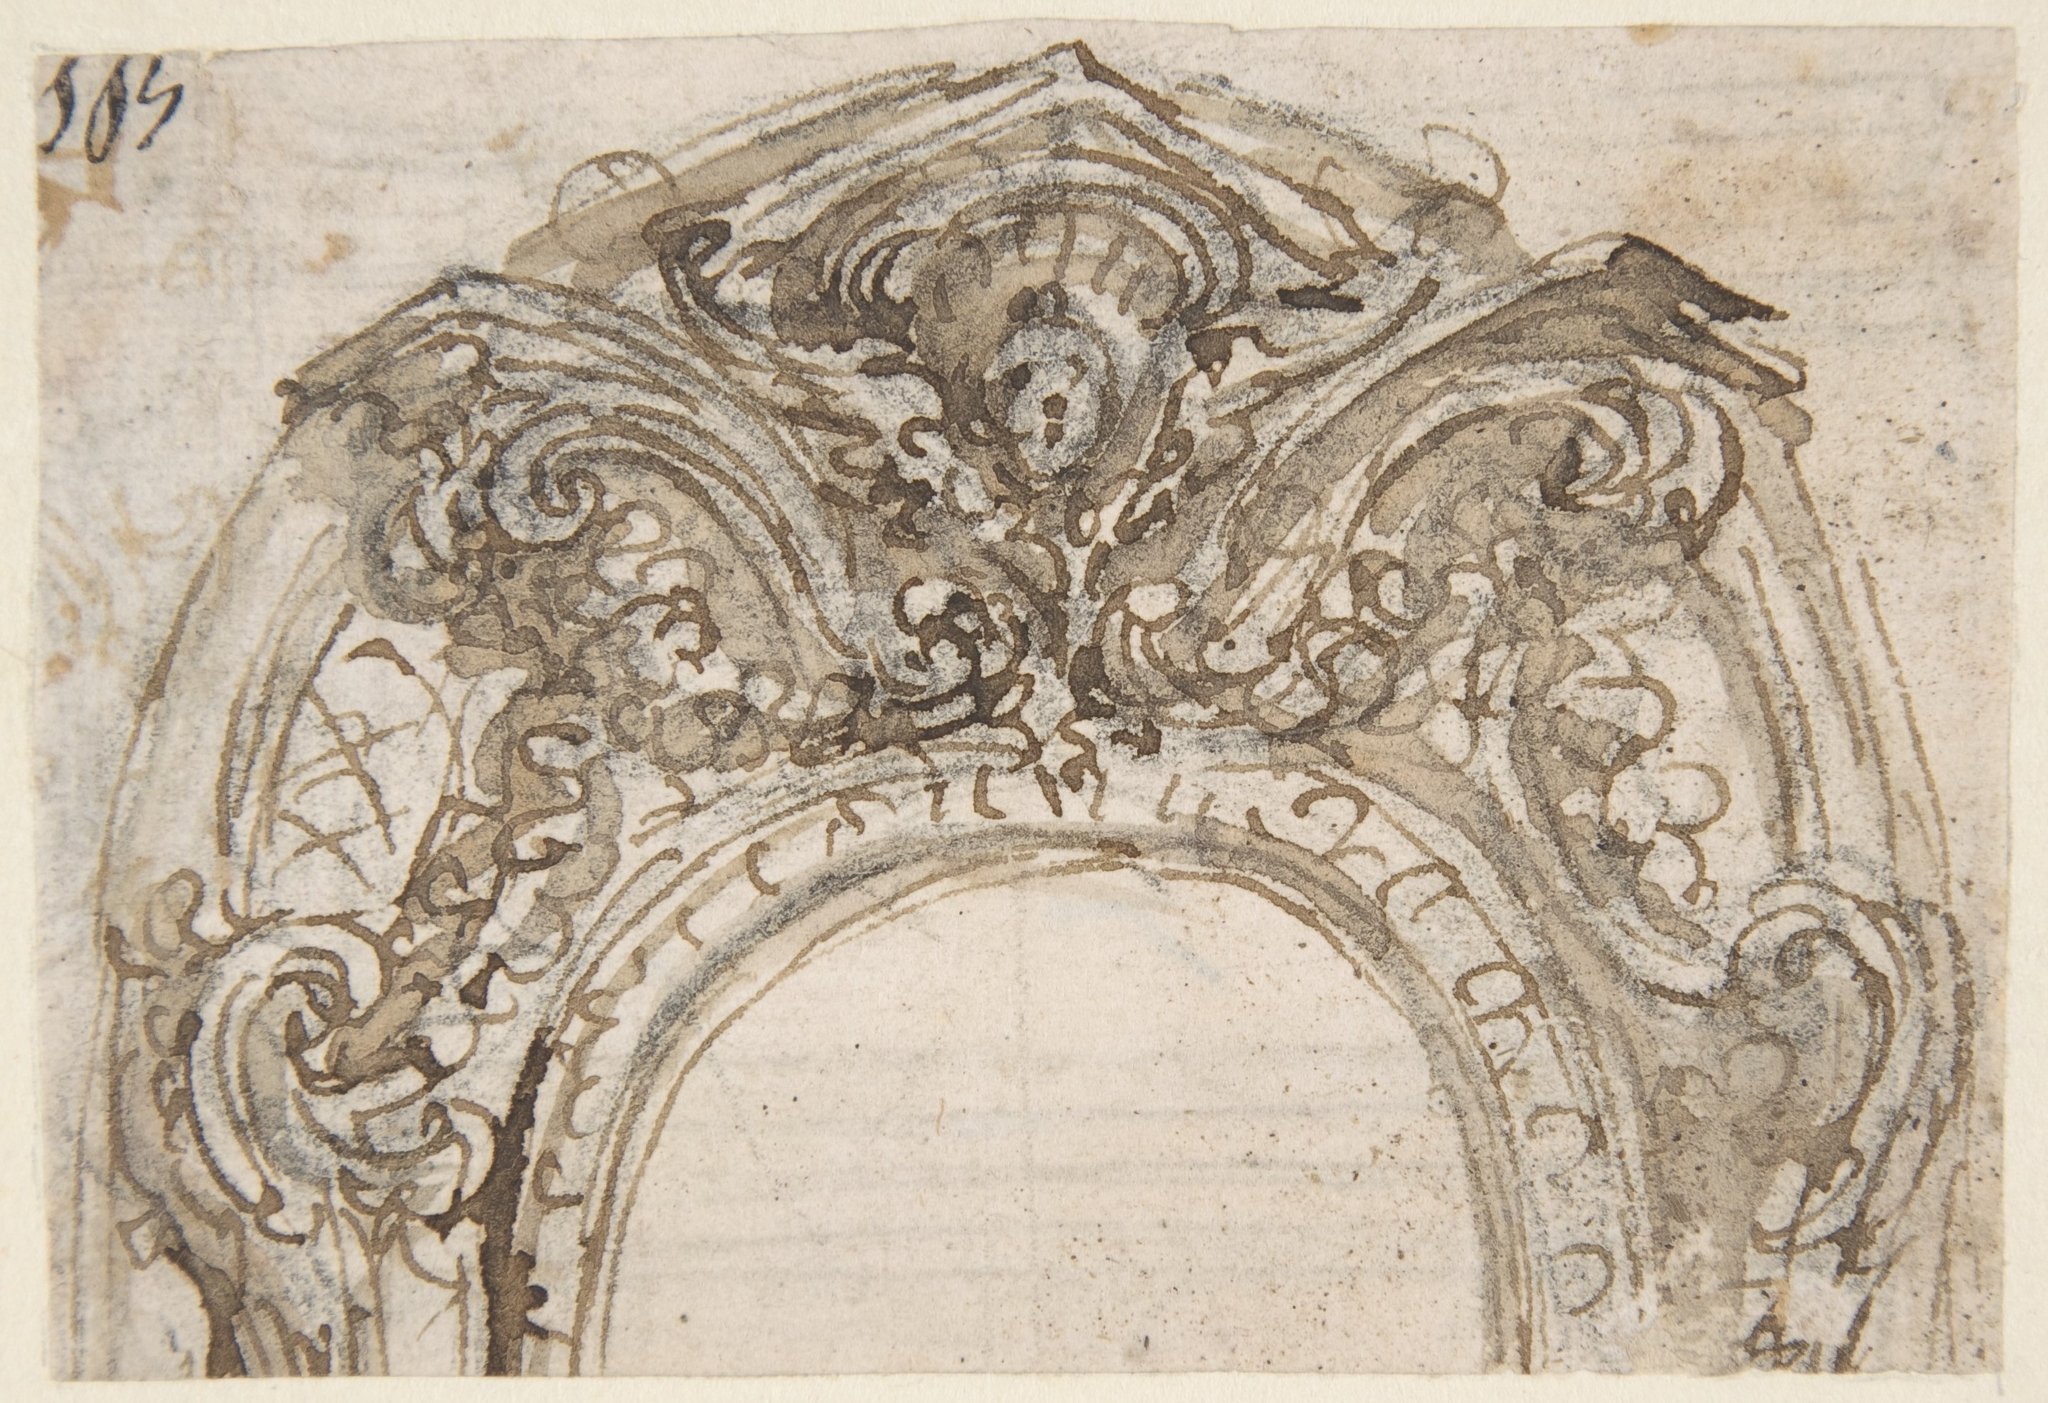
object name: drawing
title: Design for the Top of an Arch, Decorated with a Cherub (recto); Design for the Frame of a Frieze (verso)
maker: giovanni battista foggini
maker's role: artist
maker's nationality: italian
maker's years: 1652-1725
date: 1672-1725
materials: chalk, ink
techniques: brush, pen, wash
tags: arches,ornament